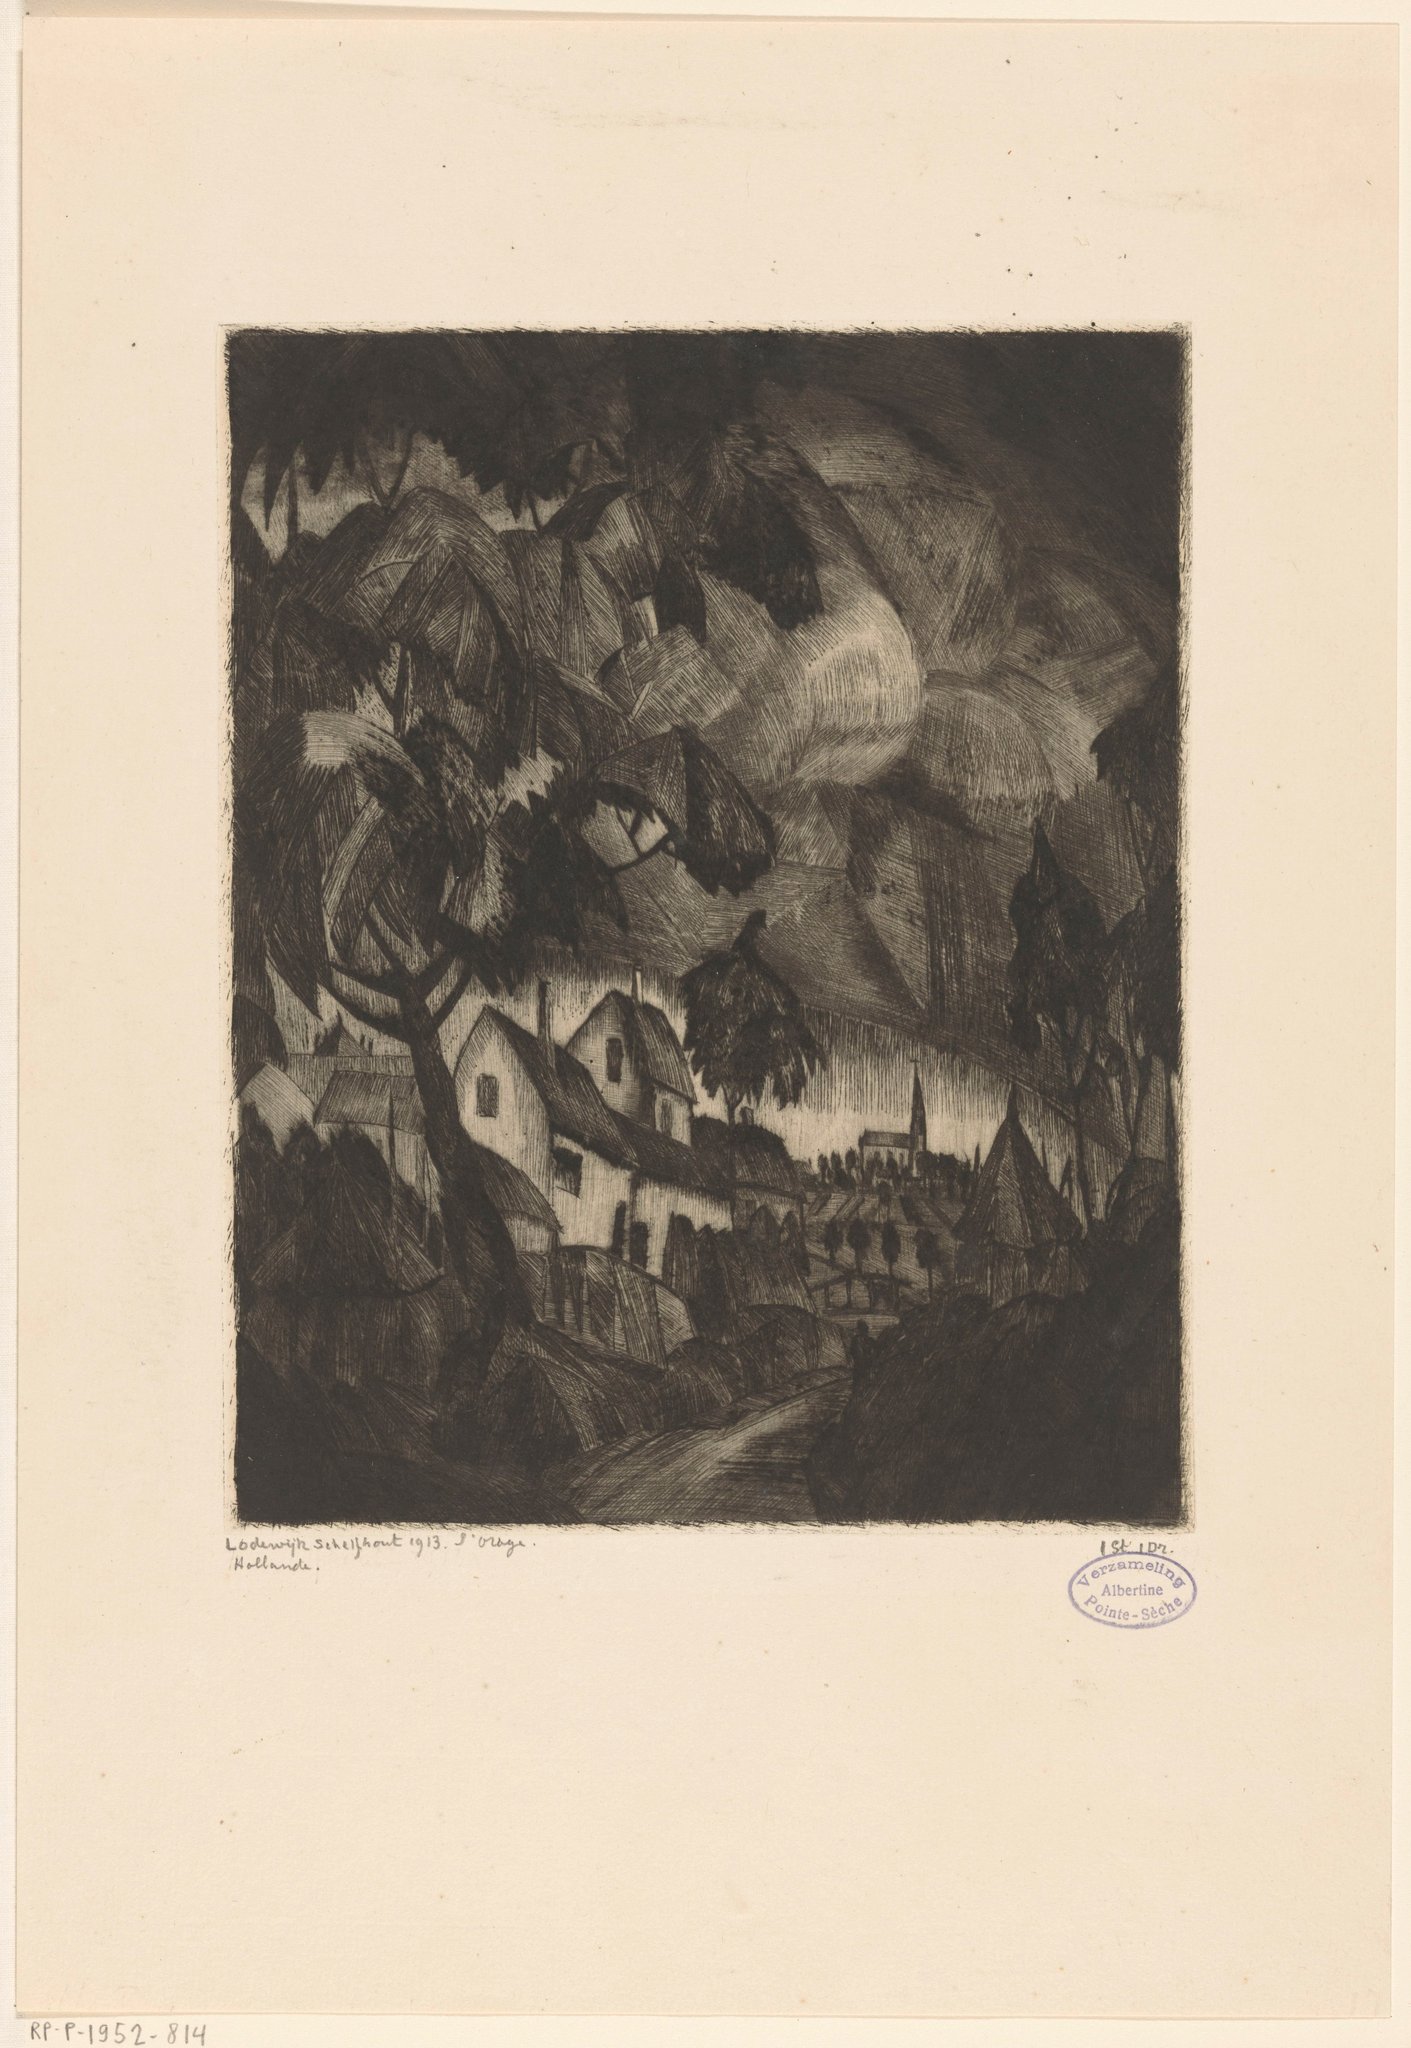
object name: print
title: Onweersbui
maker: lodewijk schelfhout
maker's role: draughtsman, print maker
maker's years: 1881-1943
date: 1913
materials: paper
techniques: drypoint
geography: netherlands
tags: low hill country, thunderstorm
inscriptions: collector's mark: Lugt 2760, collector's mark: Lugt 5i, collector's mark: Lugt 2228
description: Een zwaarbewolkte lucht boven een heuvellandschap met bomen en huizen.